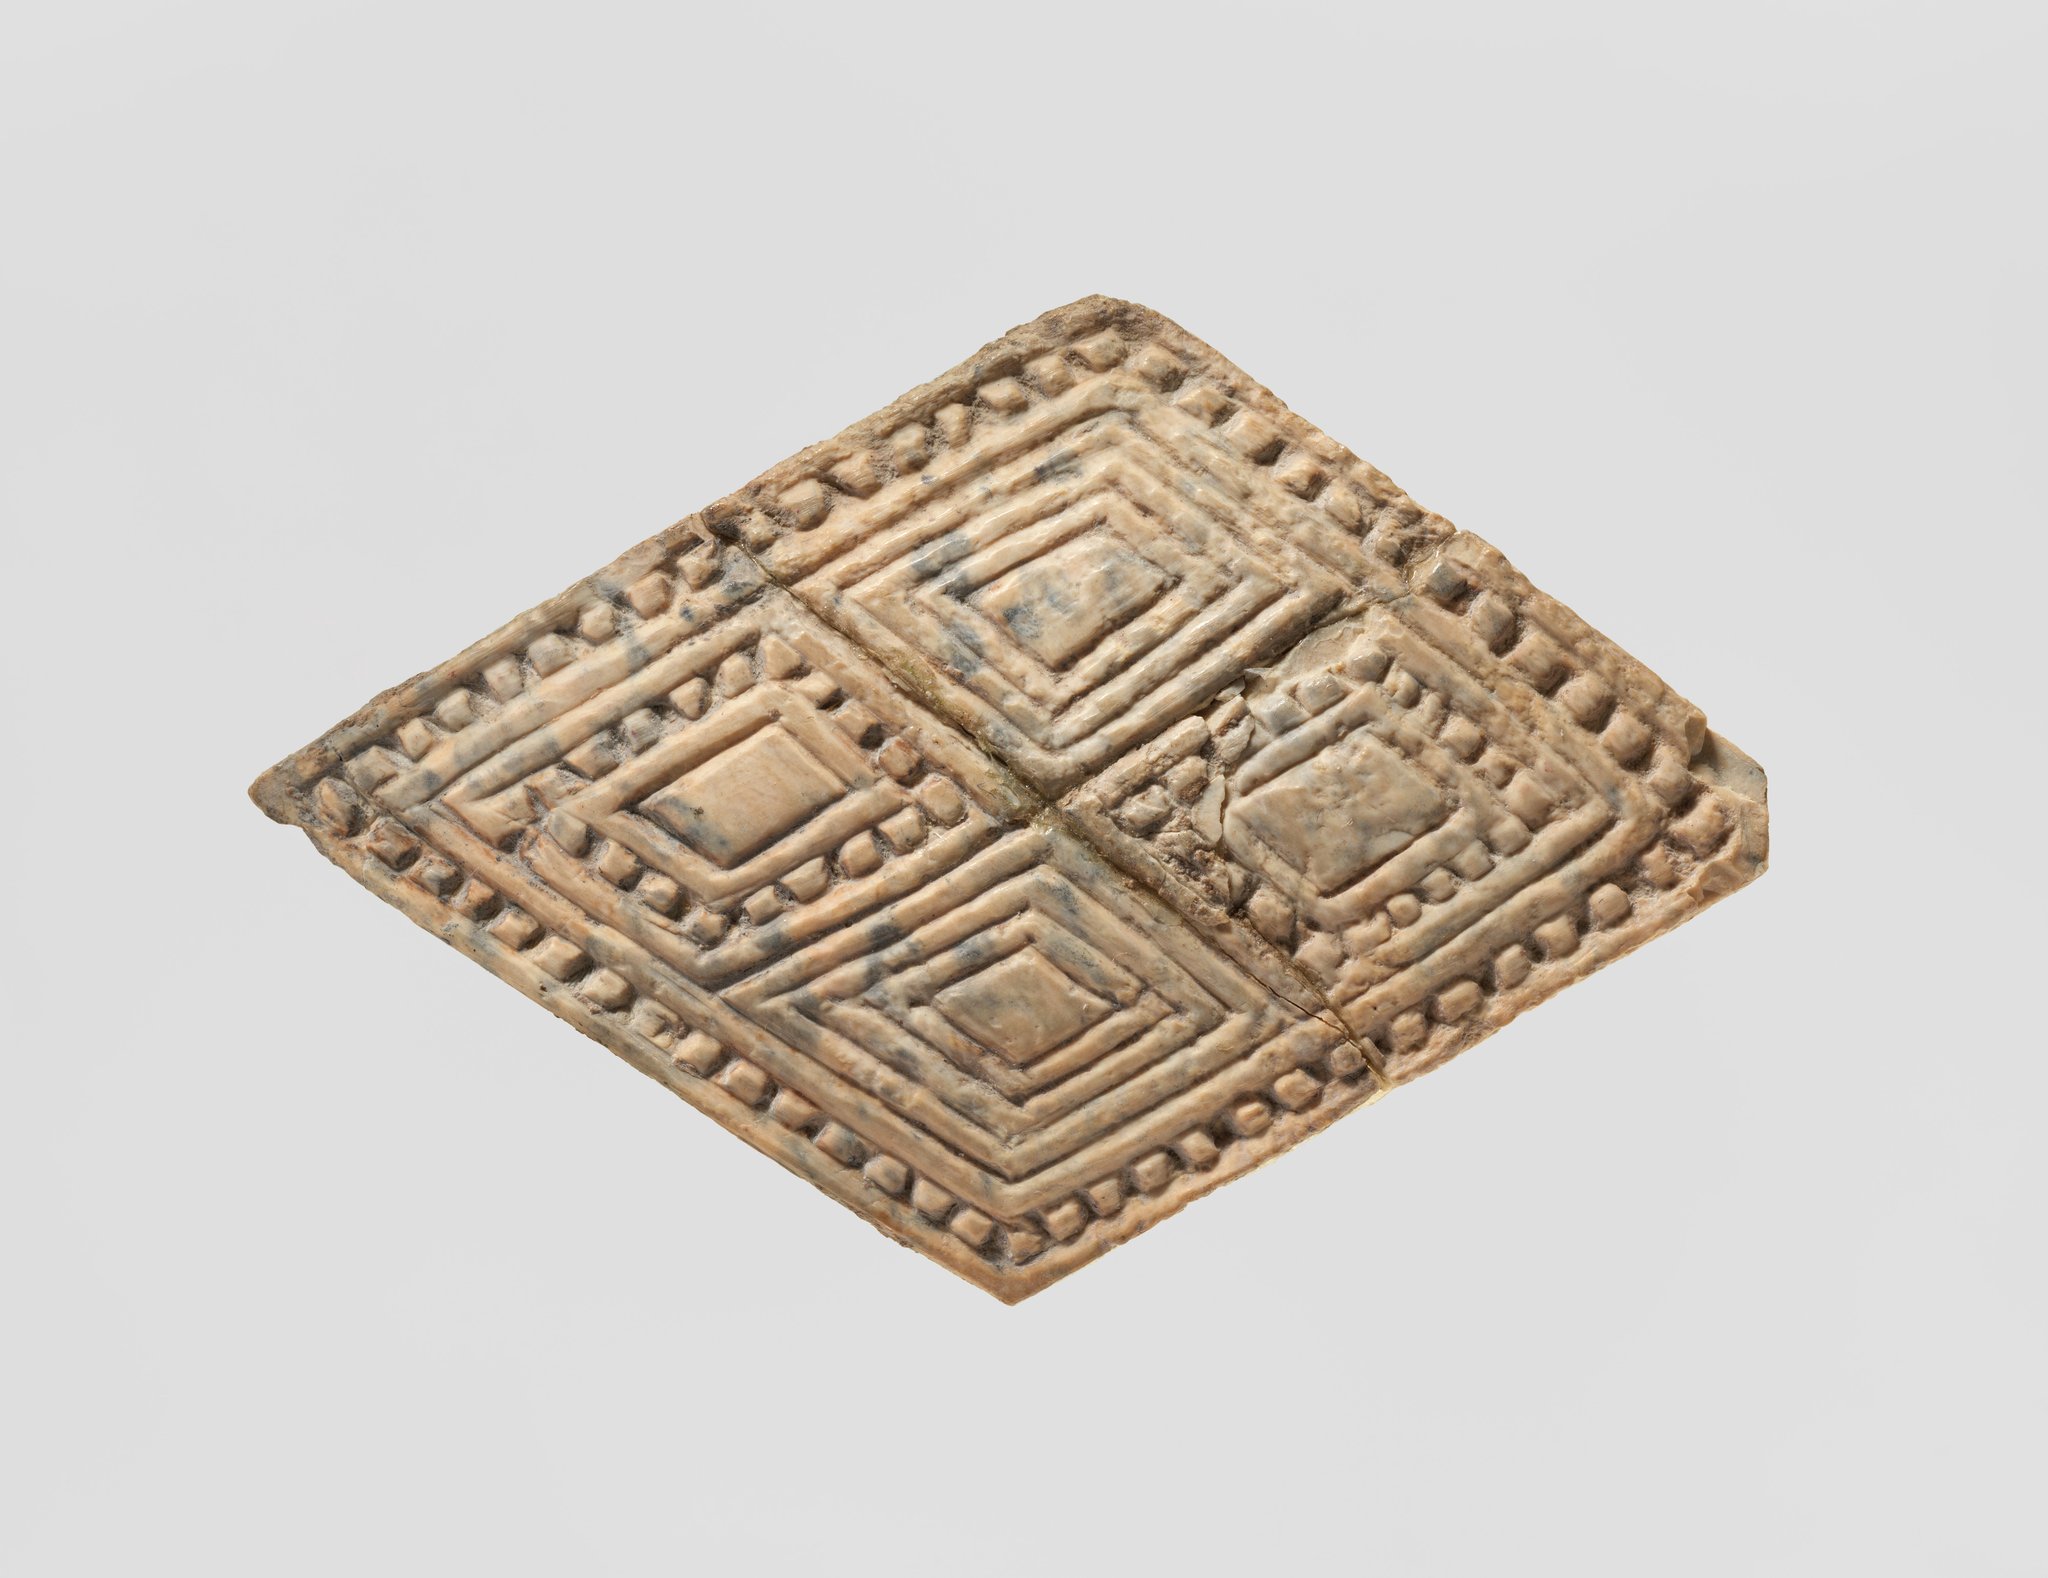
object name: relief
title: Plaque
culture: assyrian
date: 900-601 BCE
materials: ivory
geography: mesopotamia